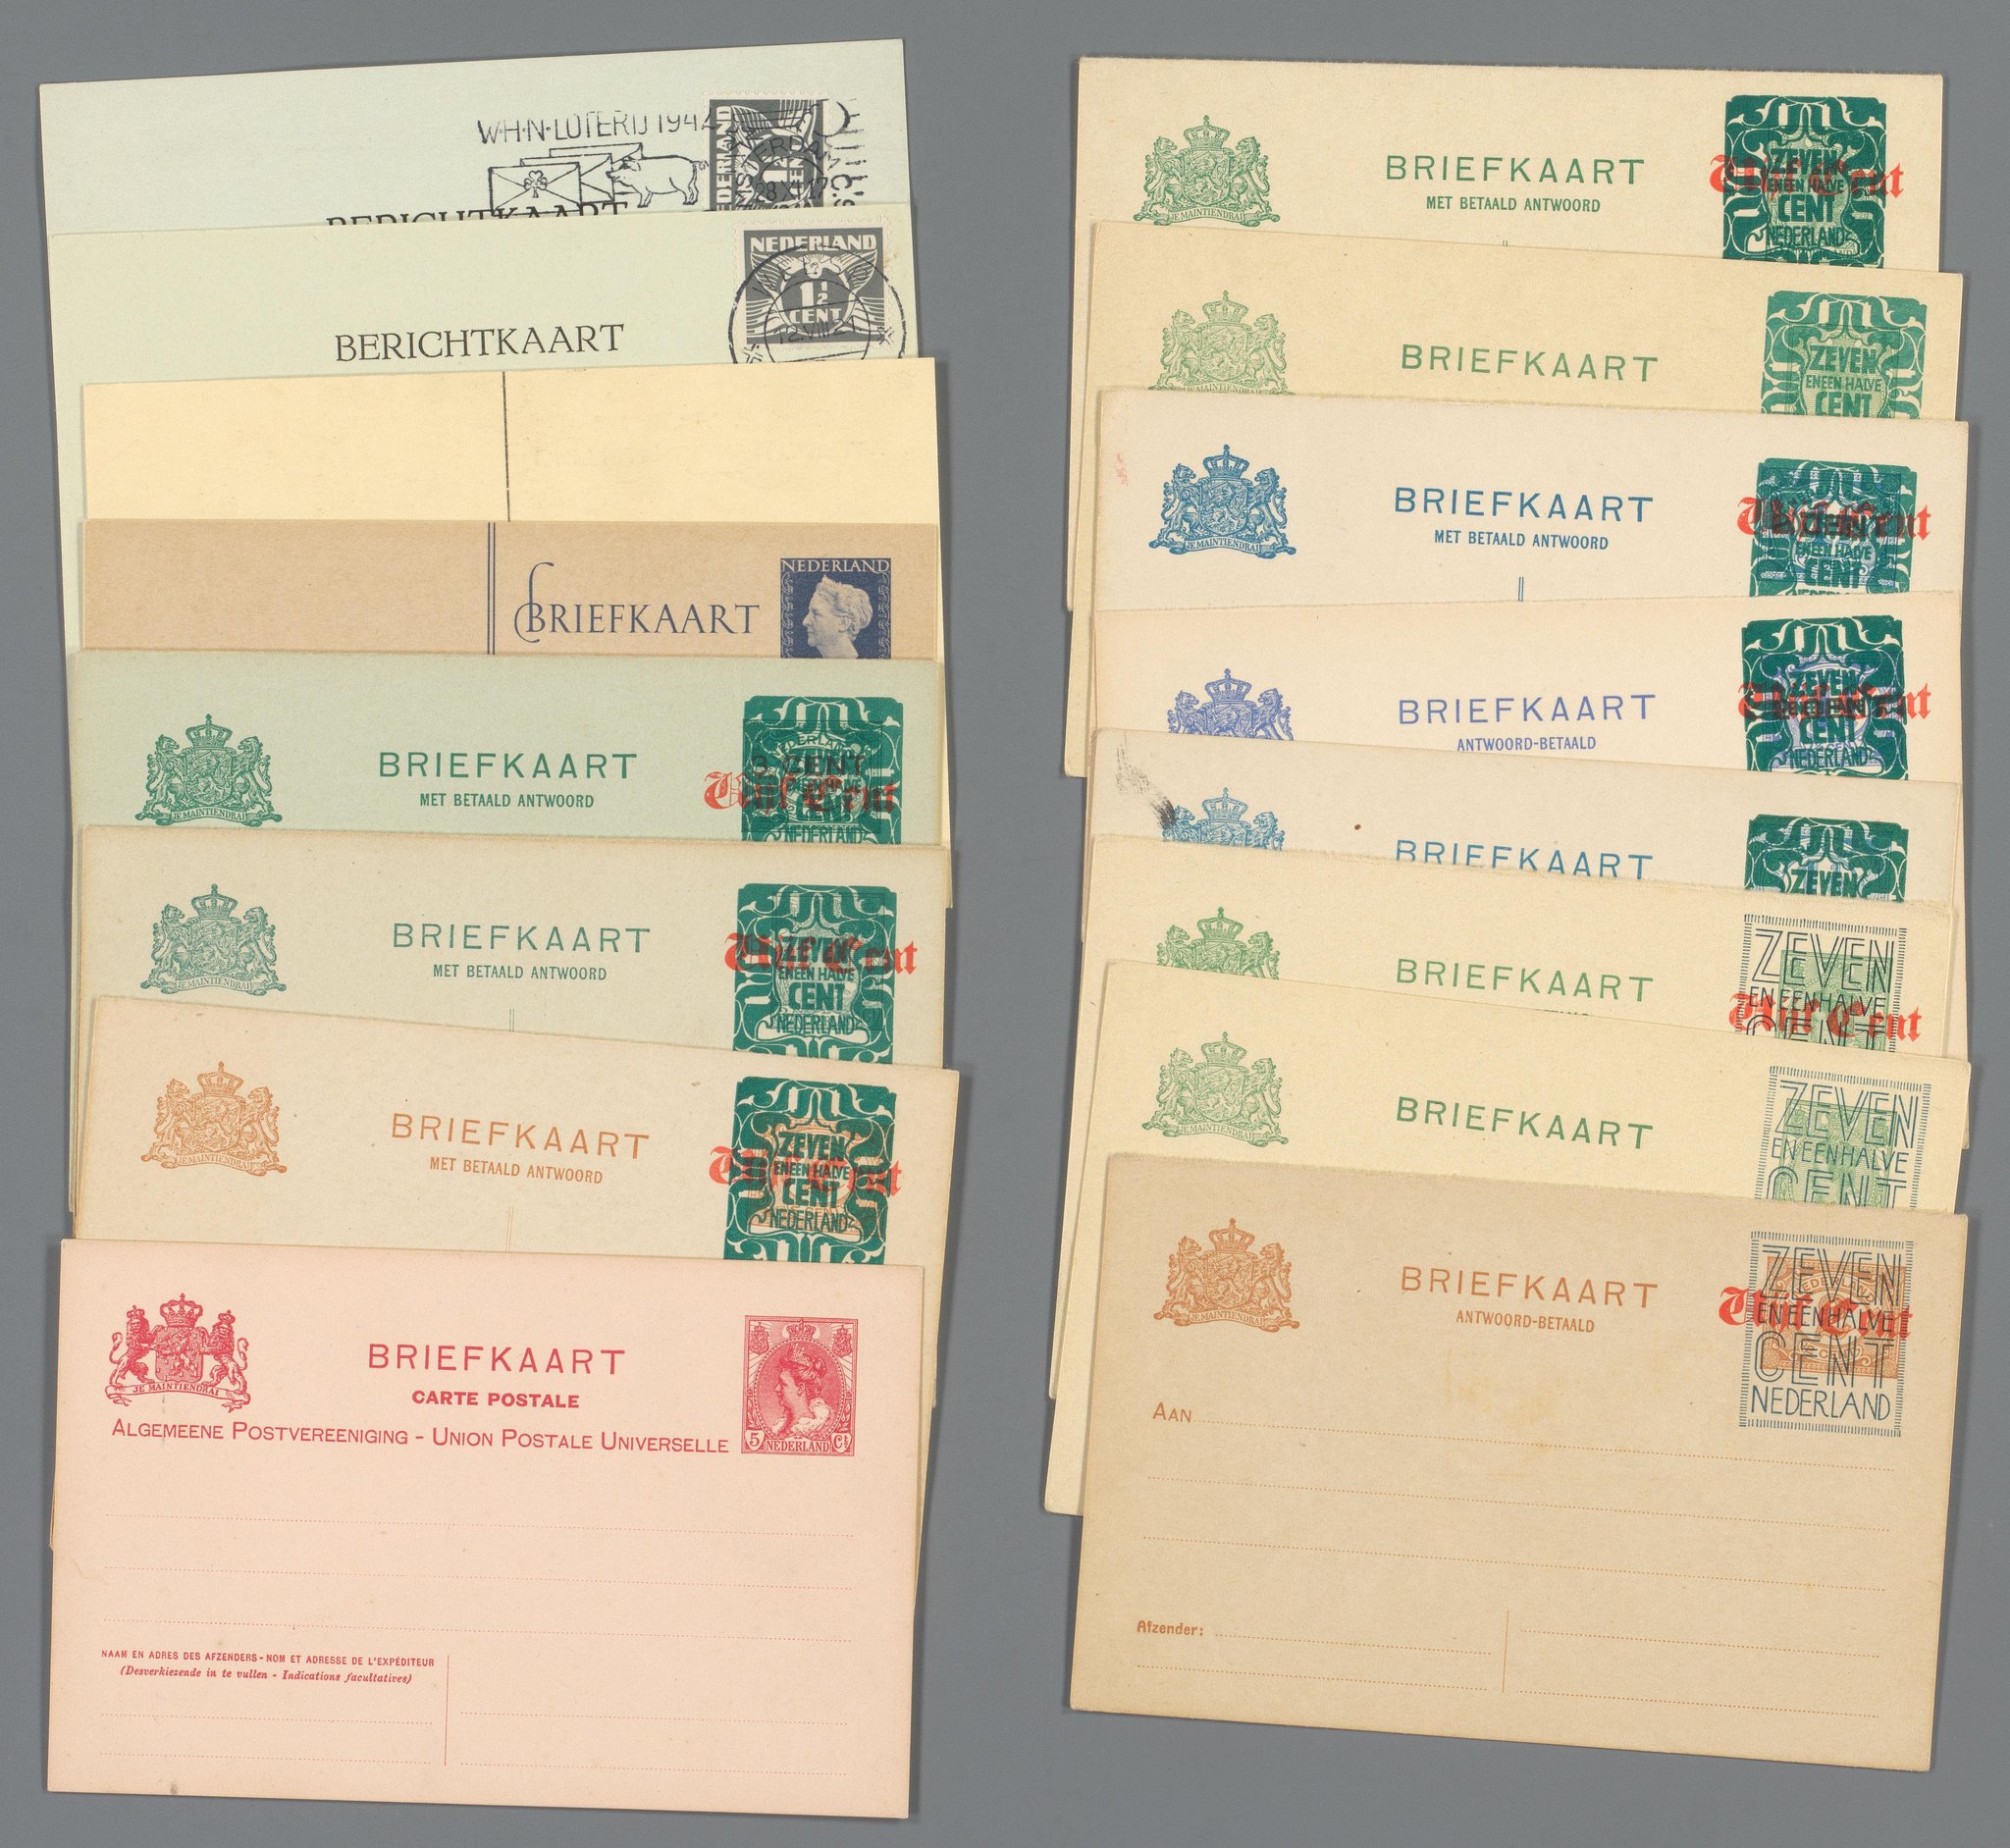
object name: postcard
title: 21 briefkaarten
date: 1900-1942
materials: paper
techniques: lithograph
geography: netherlands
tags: stamp (~ postal matter), postcard, picture-postcard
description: Groep van 21 Nederlandse briefkaarten, waarvan 18 onbeschreven. Uit de periode ca. 1900-1942.